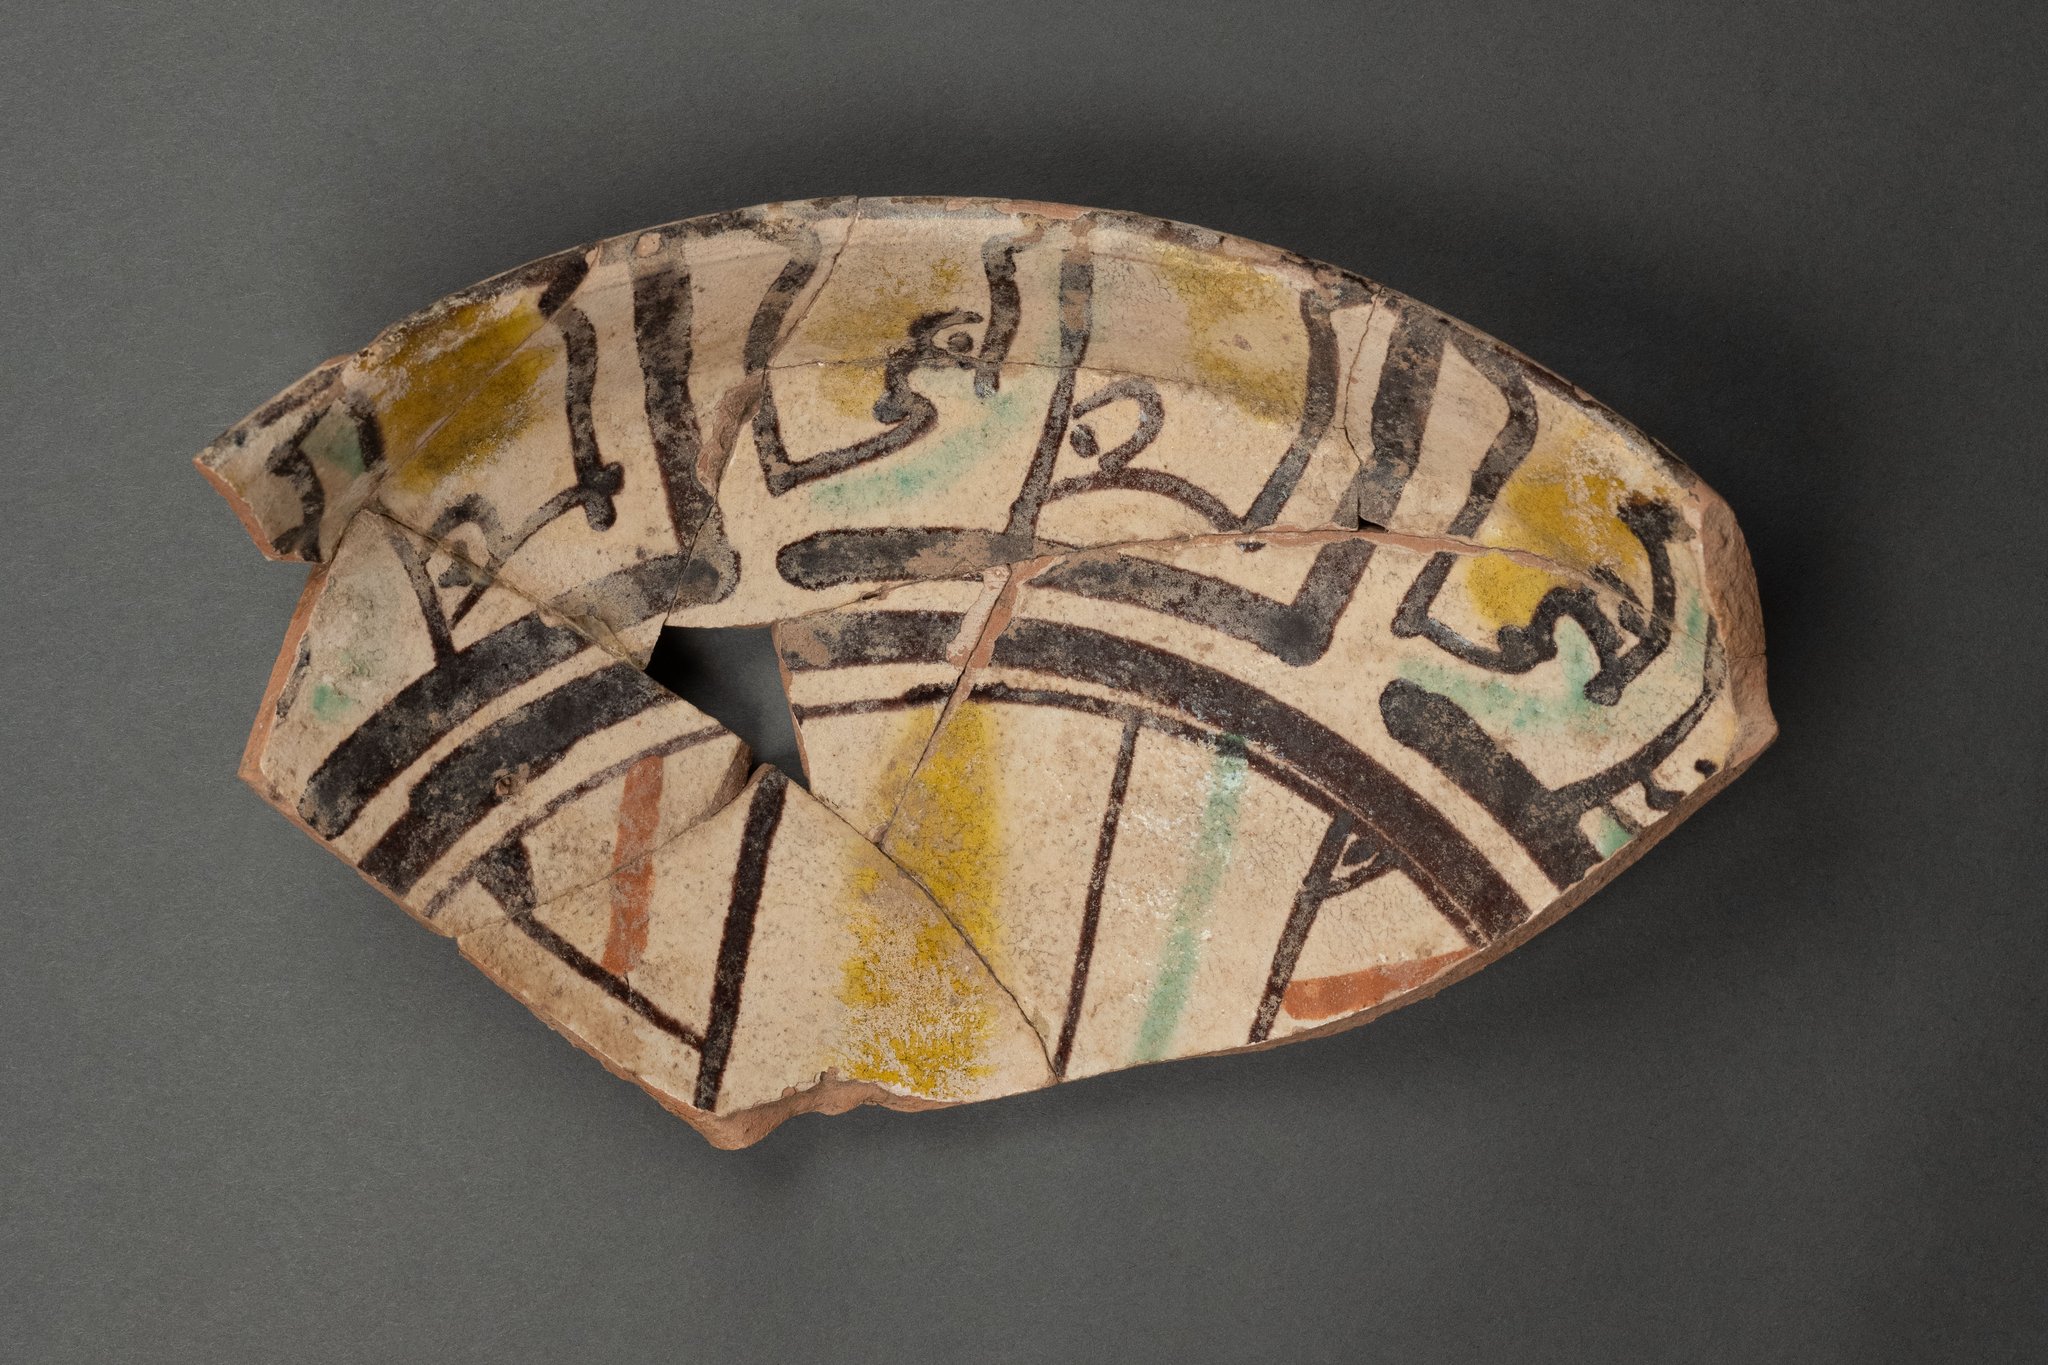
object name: ceramic fragment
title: Fragment of a Bowl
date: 801-900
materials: earthenware, glaze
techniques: polychrome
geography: iran